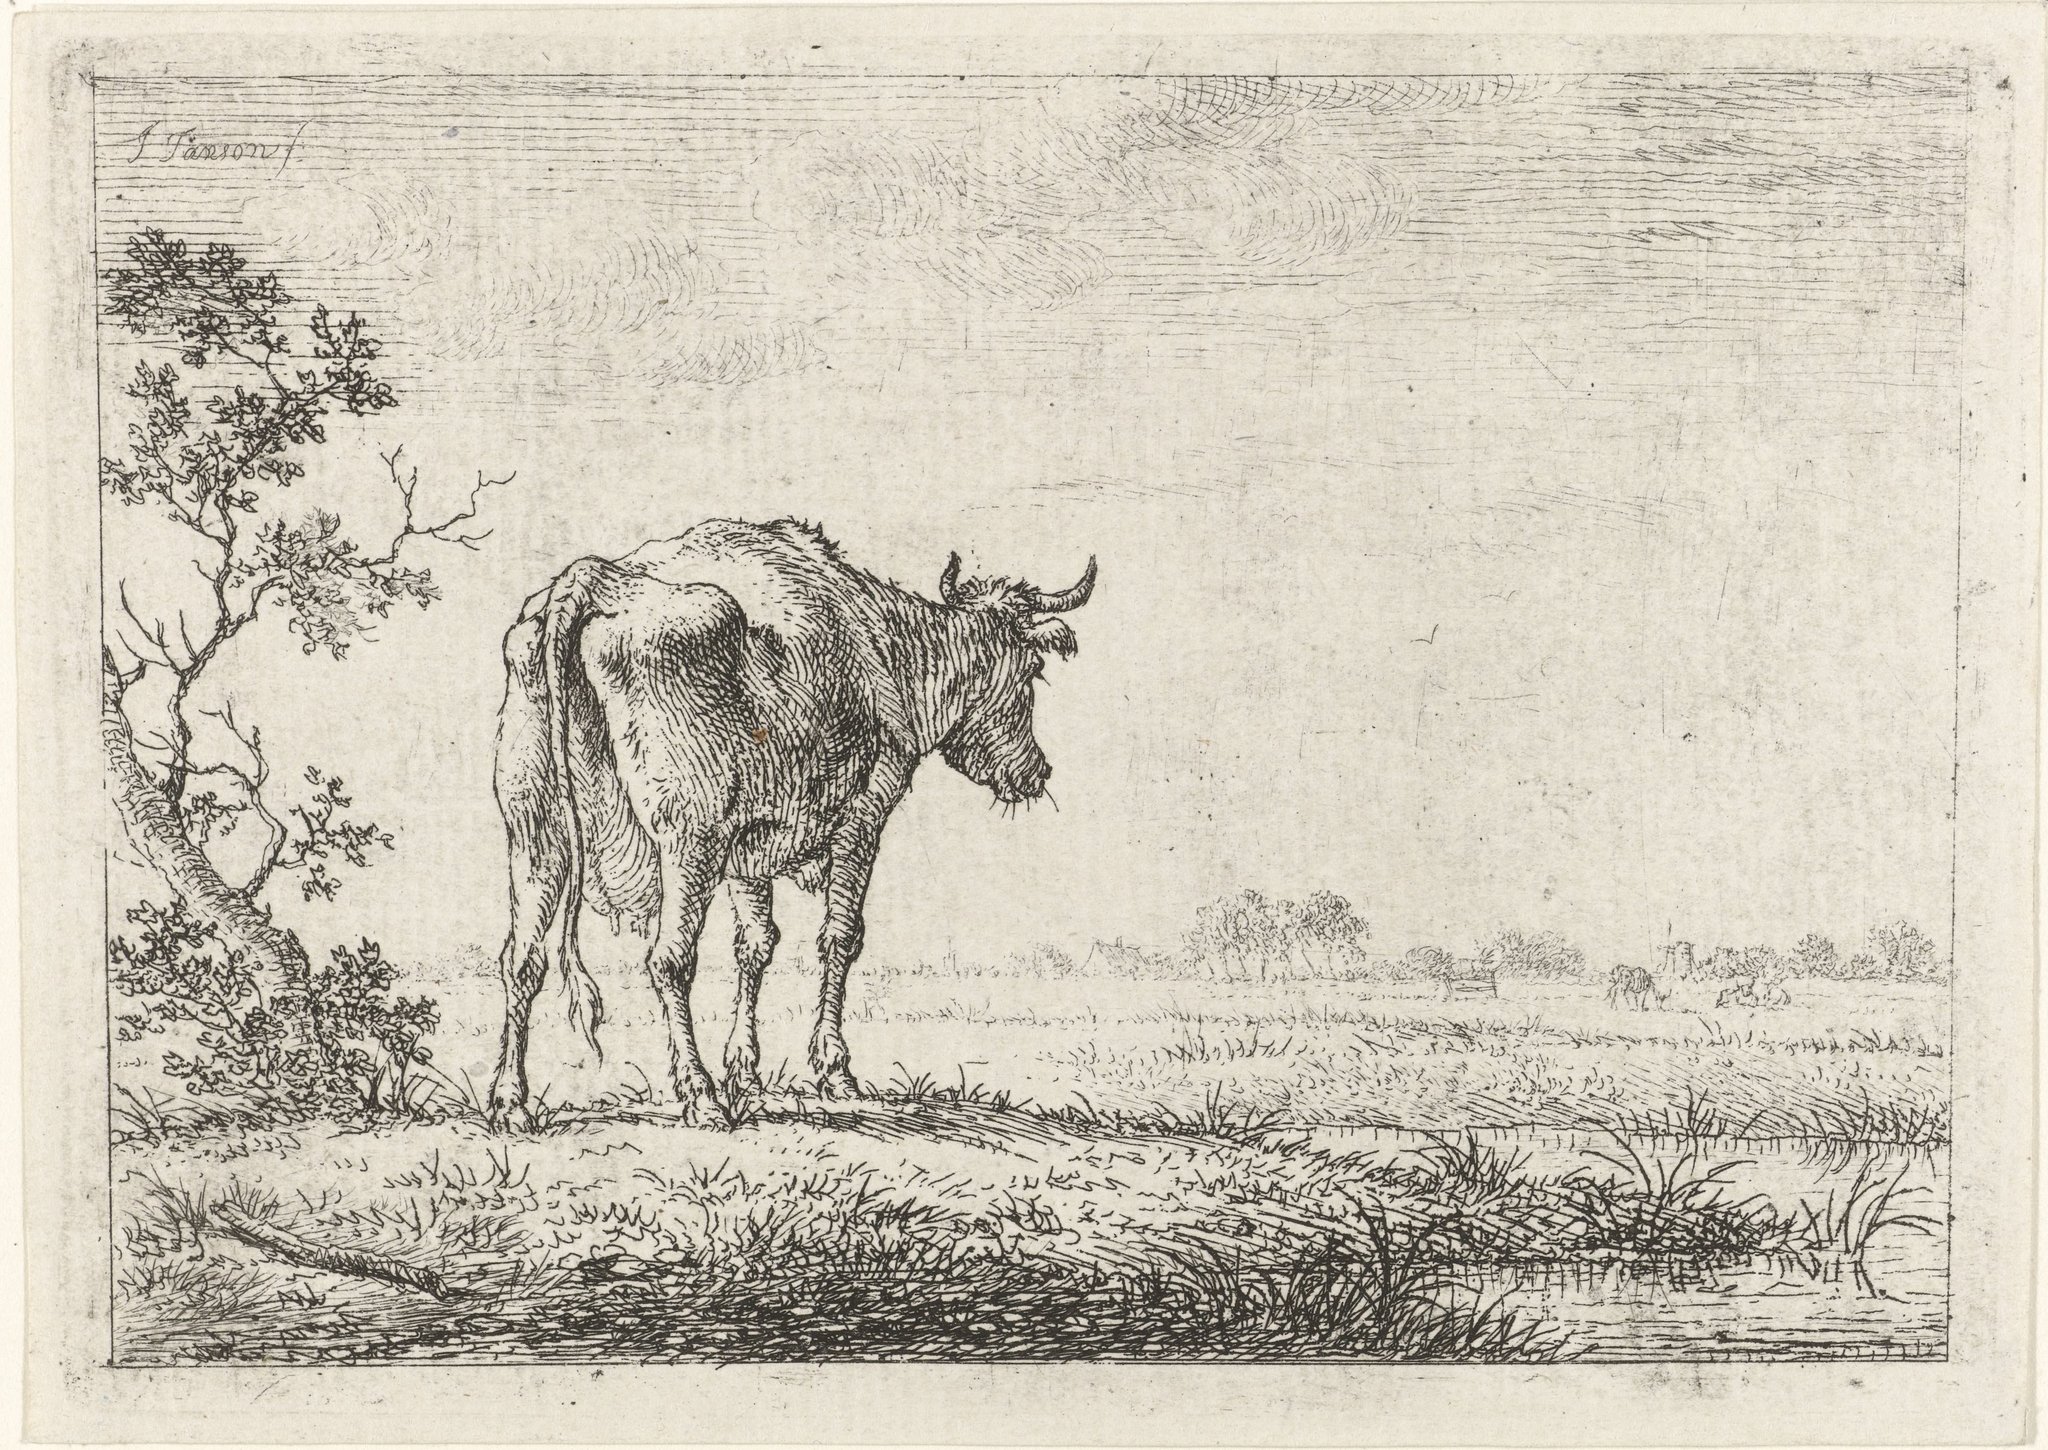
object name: print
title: Koe in weiland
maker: johannes janson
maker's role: draughtsman, painter, print maker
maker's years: 1729-1784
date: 1761-1784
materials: paper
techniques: etching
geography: leiden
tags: cow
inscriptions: collector's mark: Lugt 2228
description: Koe in weiland, staand bij water, op de rug gezien. Prent uit een serie met landschappen met vee.